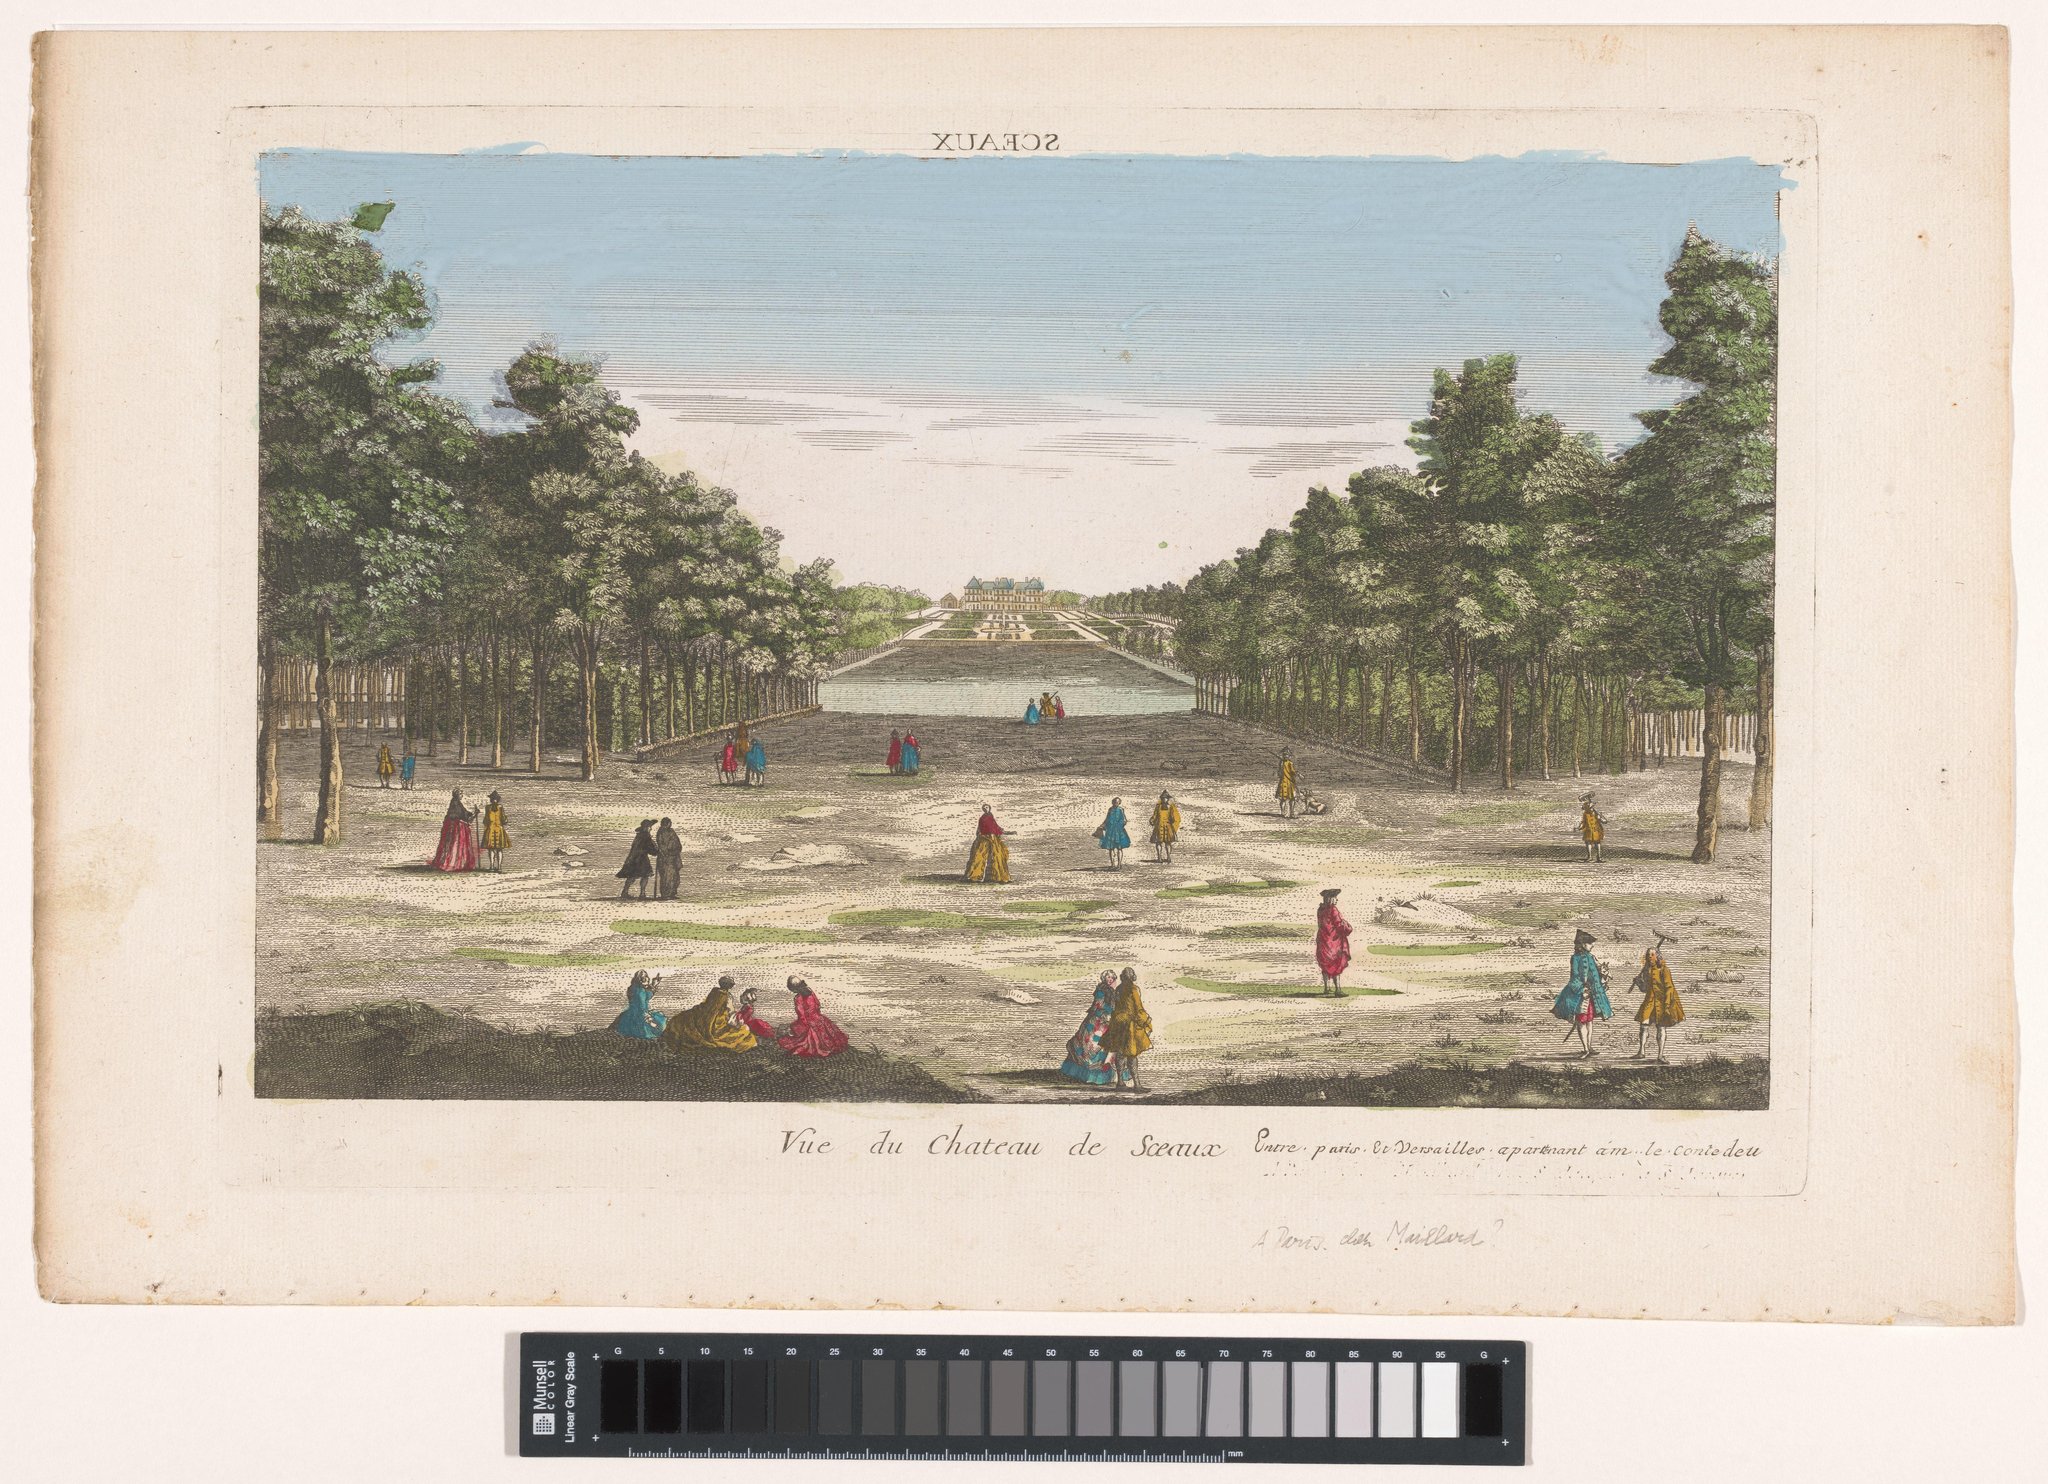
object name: print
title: Vue du Chateau de Sceaux entre Paris et Versailles apartenant am le contedeu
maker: Anonymous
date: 1700-1799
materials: paper, watercolor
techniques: brush, etching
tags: garden, ornamental plants, civic architecture; edifices; dwellings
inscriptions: collector's mark: Lugt 2166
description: Op de achtergrond het Château de Sceaux.